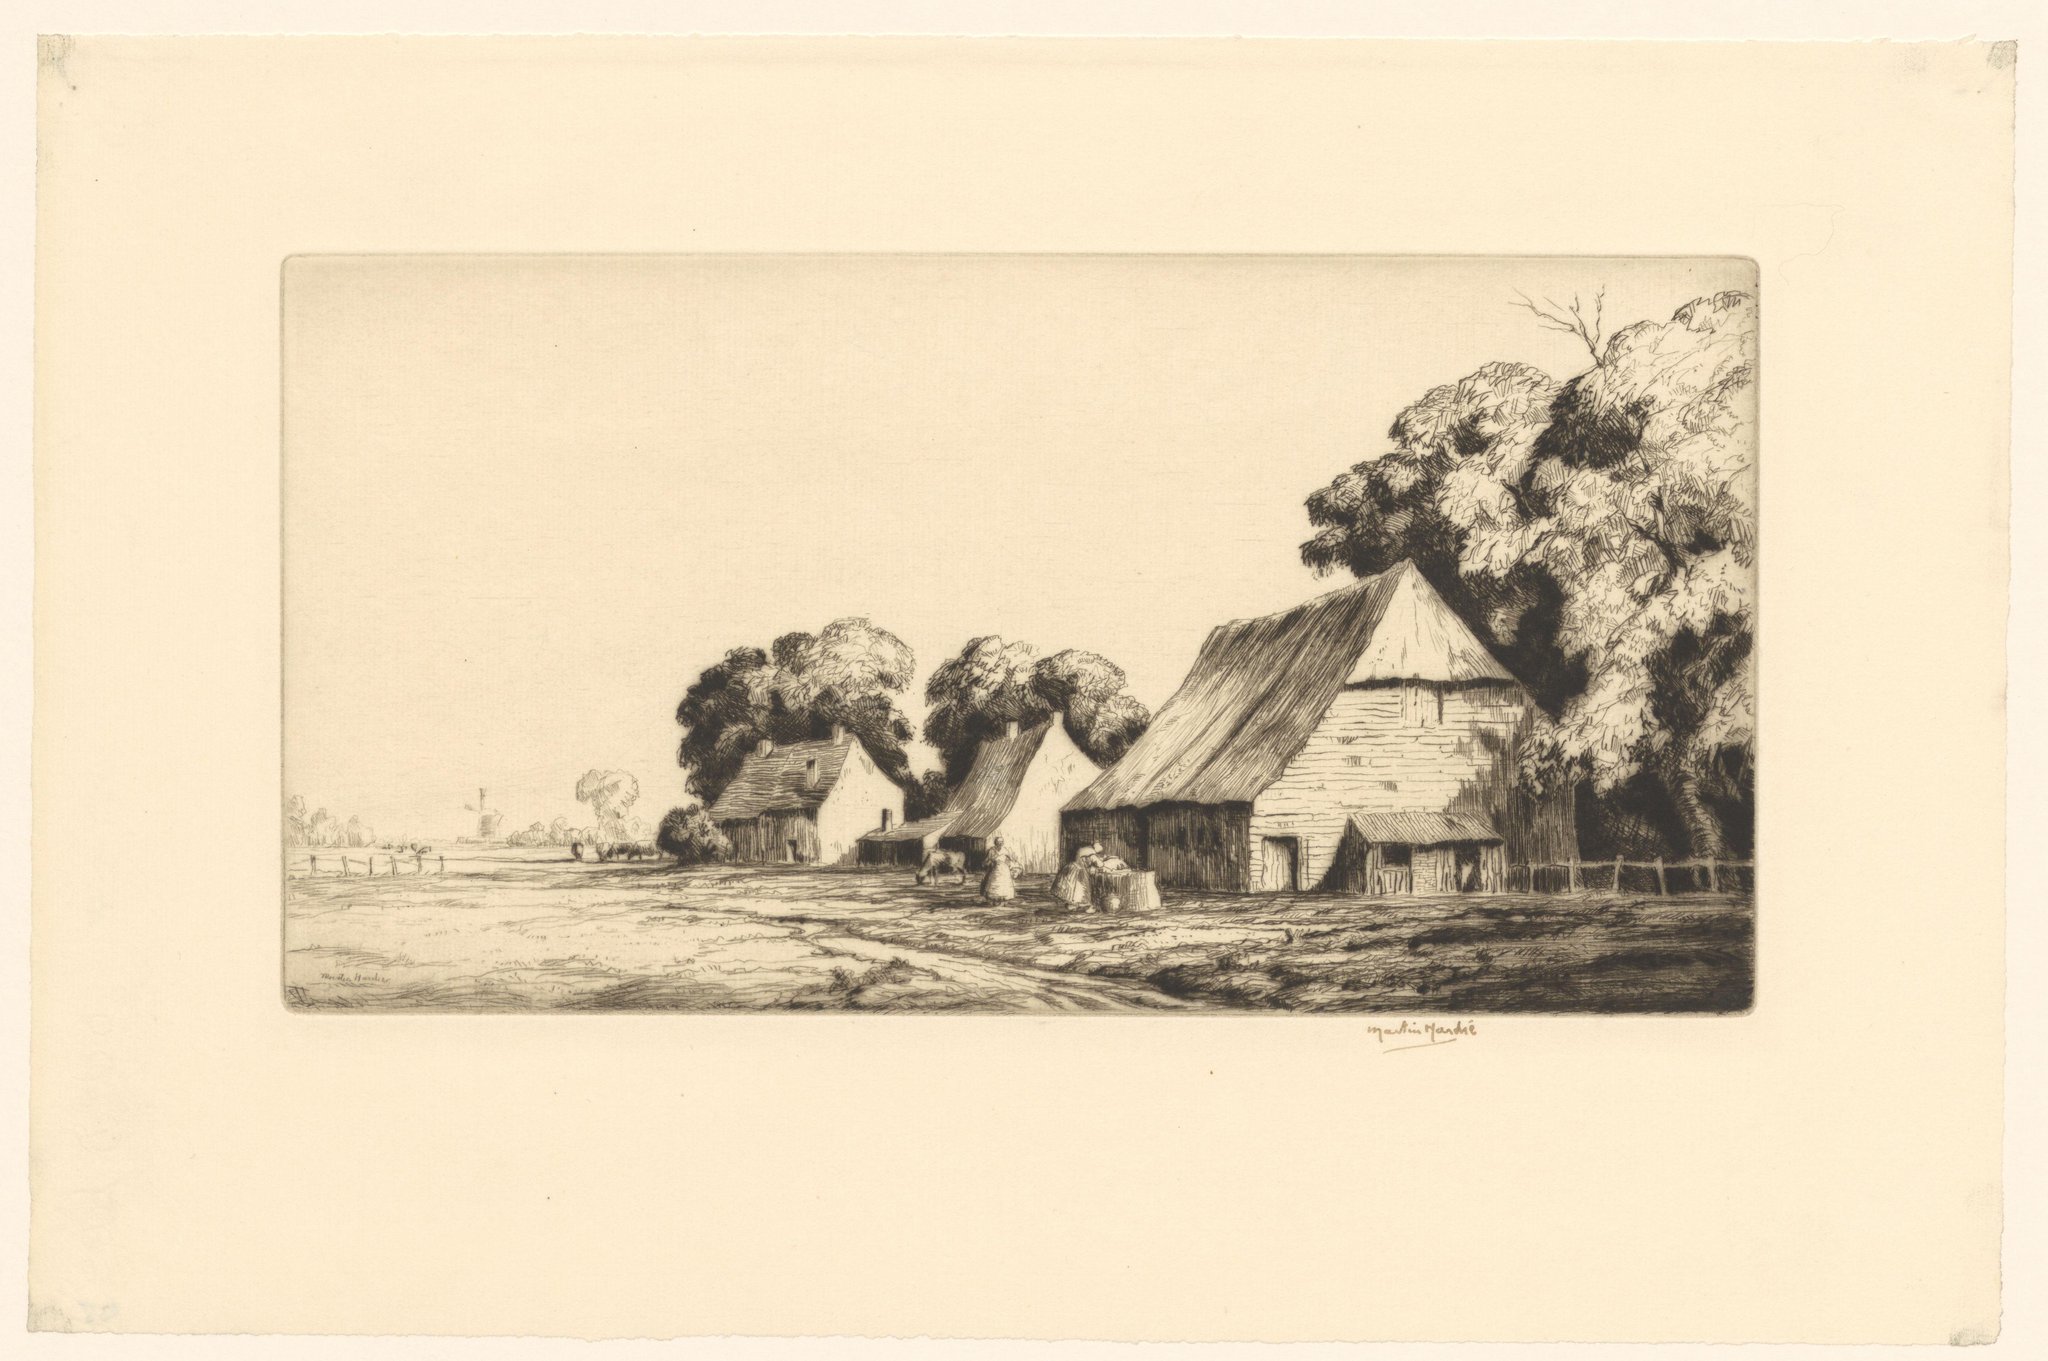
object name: print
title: Boerderij in Zeeland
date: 1929-1930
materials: paper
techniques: drypoint, etching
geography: veere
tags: cultivated land (+ landscape with figures, staffage), farm (building)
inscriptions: collector's mark: Lugt 2228, collector's mark: Lugt 2760, annotation: ‘Martin Hardie’